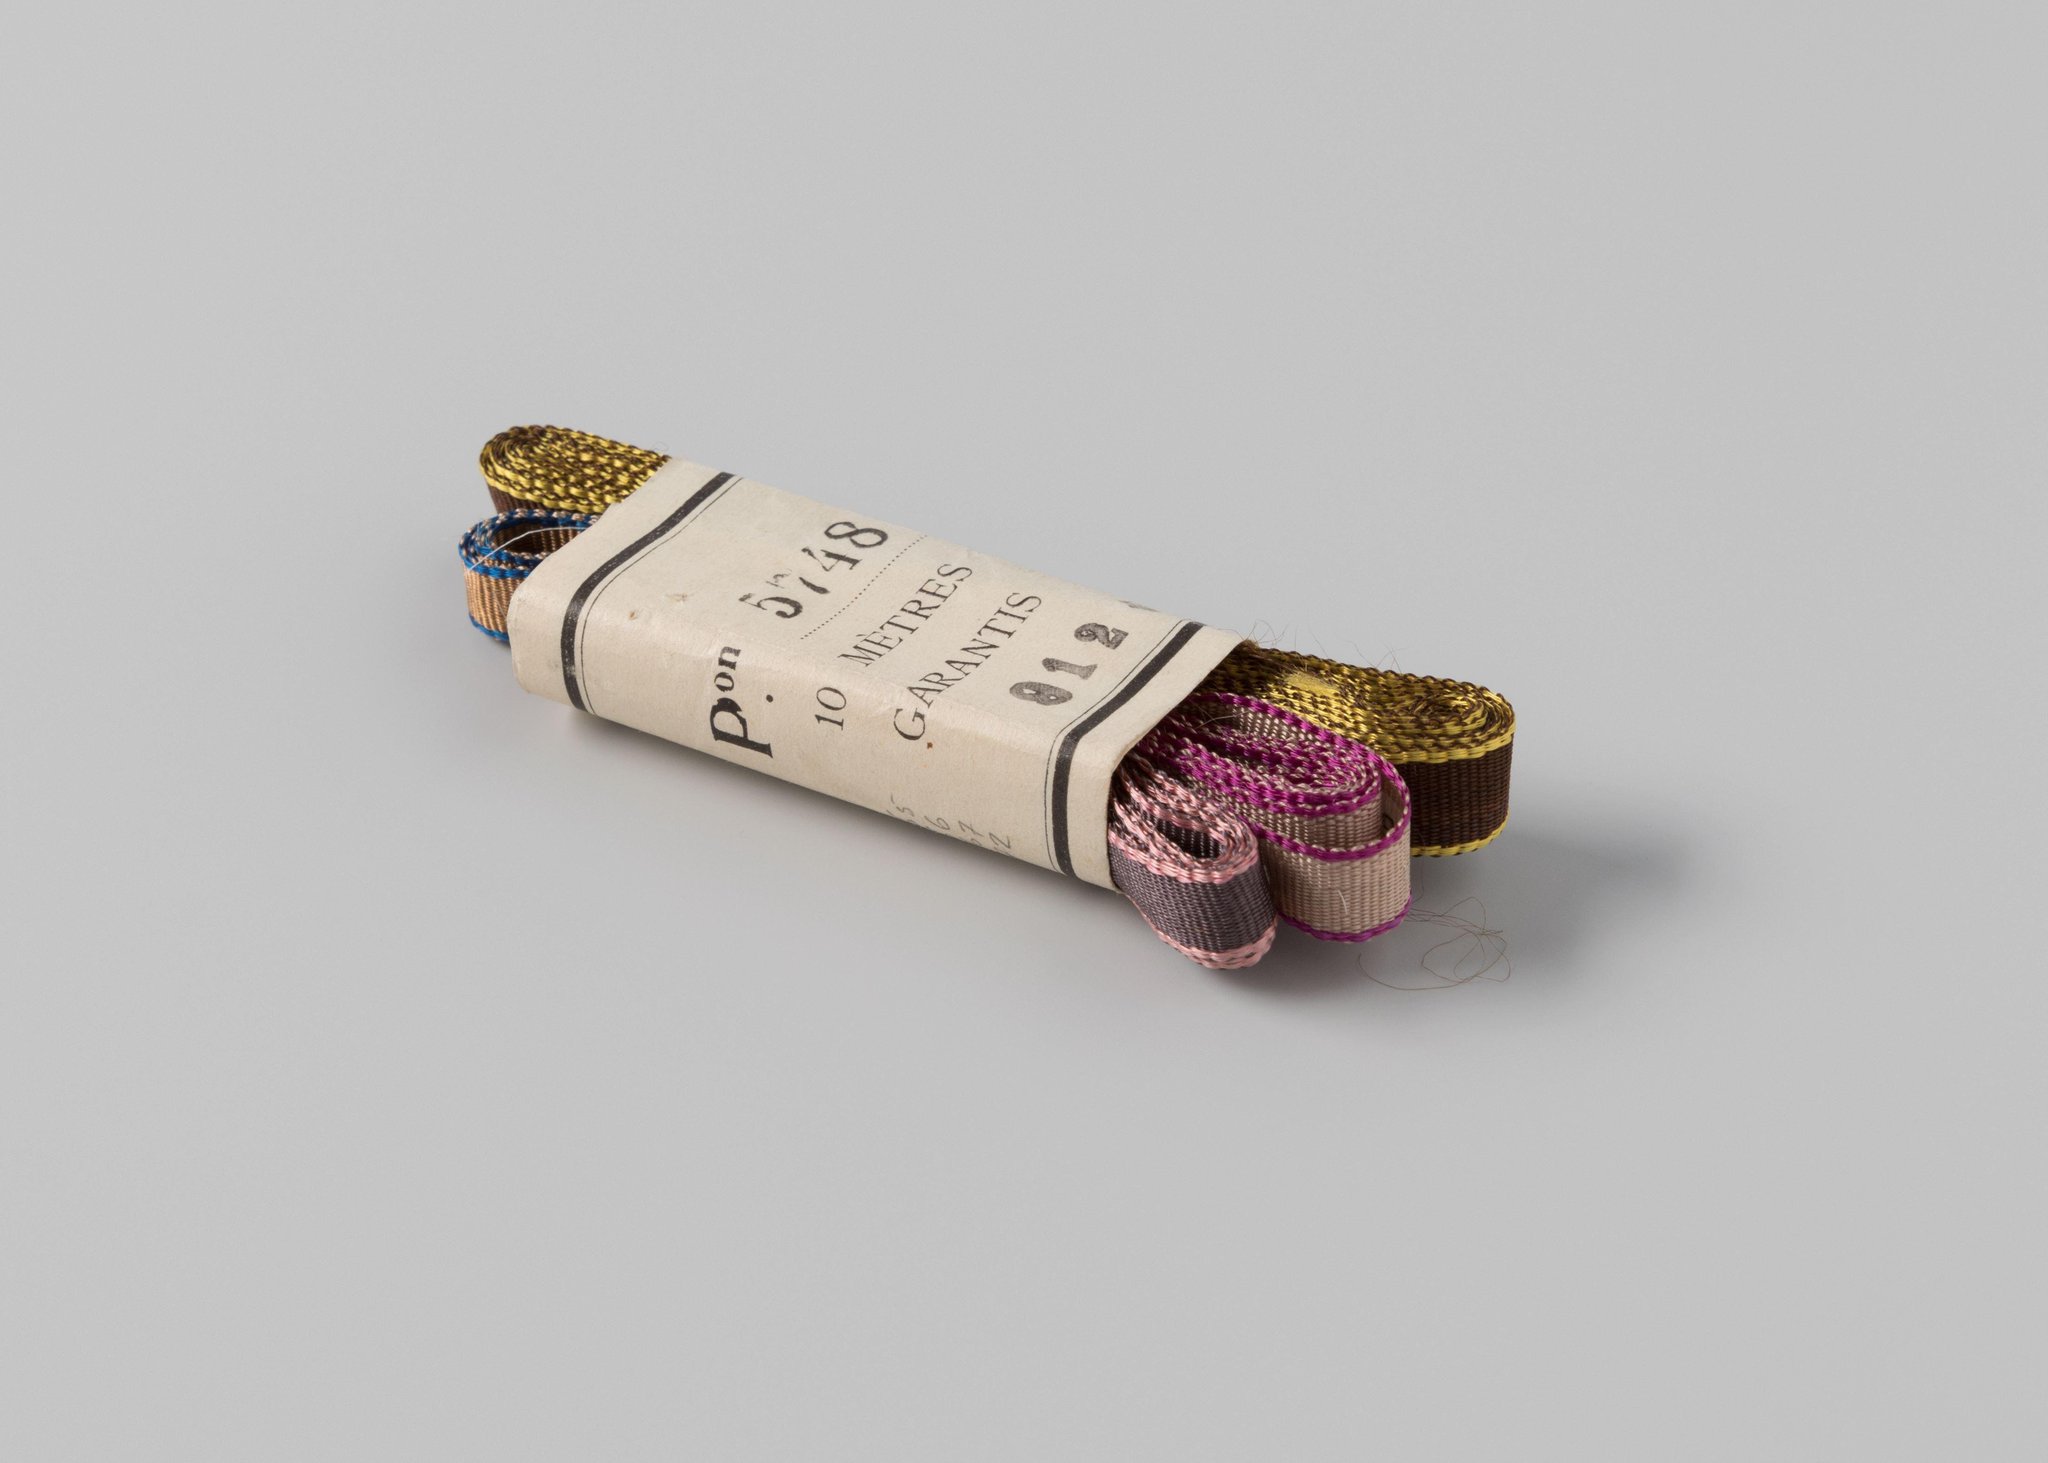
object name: braid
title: Lint, grijs aan beide zijden rose afgebiesd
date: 1890-1935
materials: textile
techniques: weave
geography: nijmegen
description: Lint, grijs aan beide zijden rose afgebiesd.